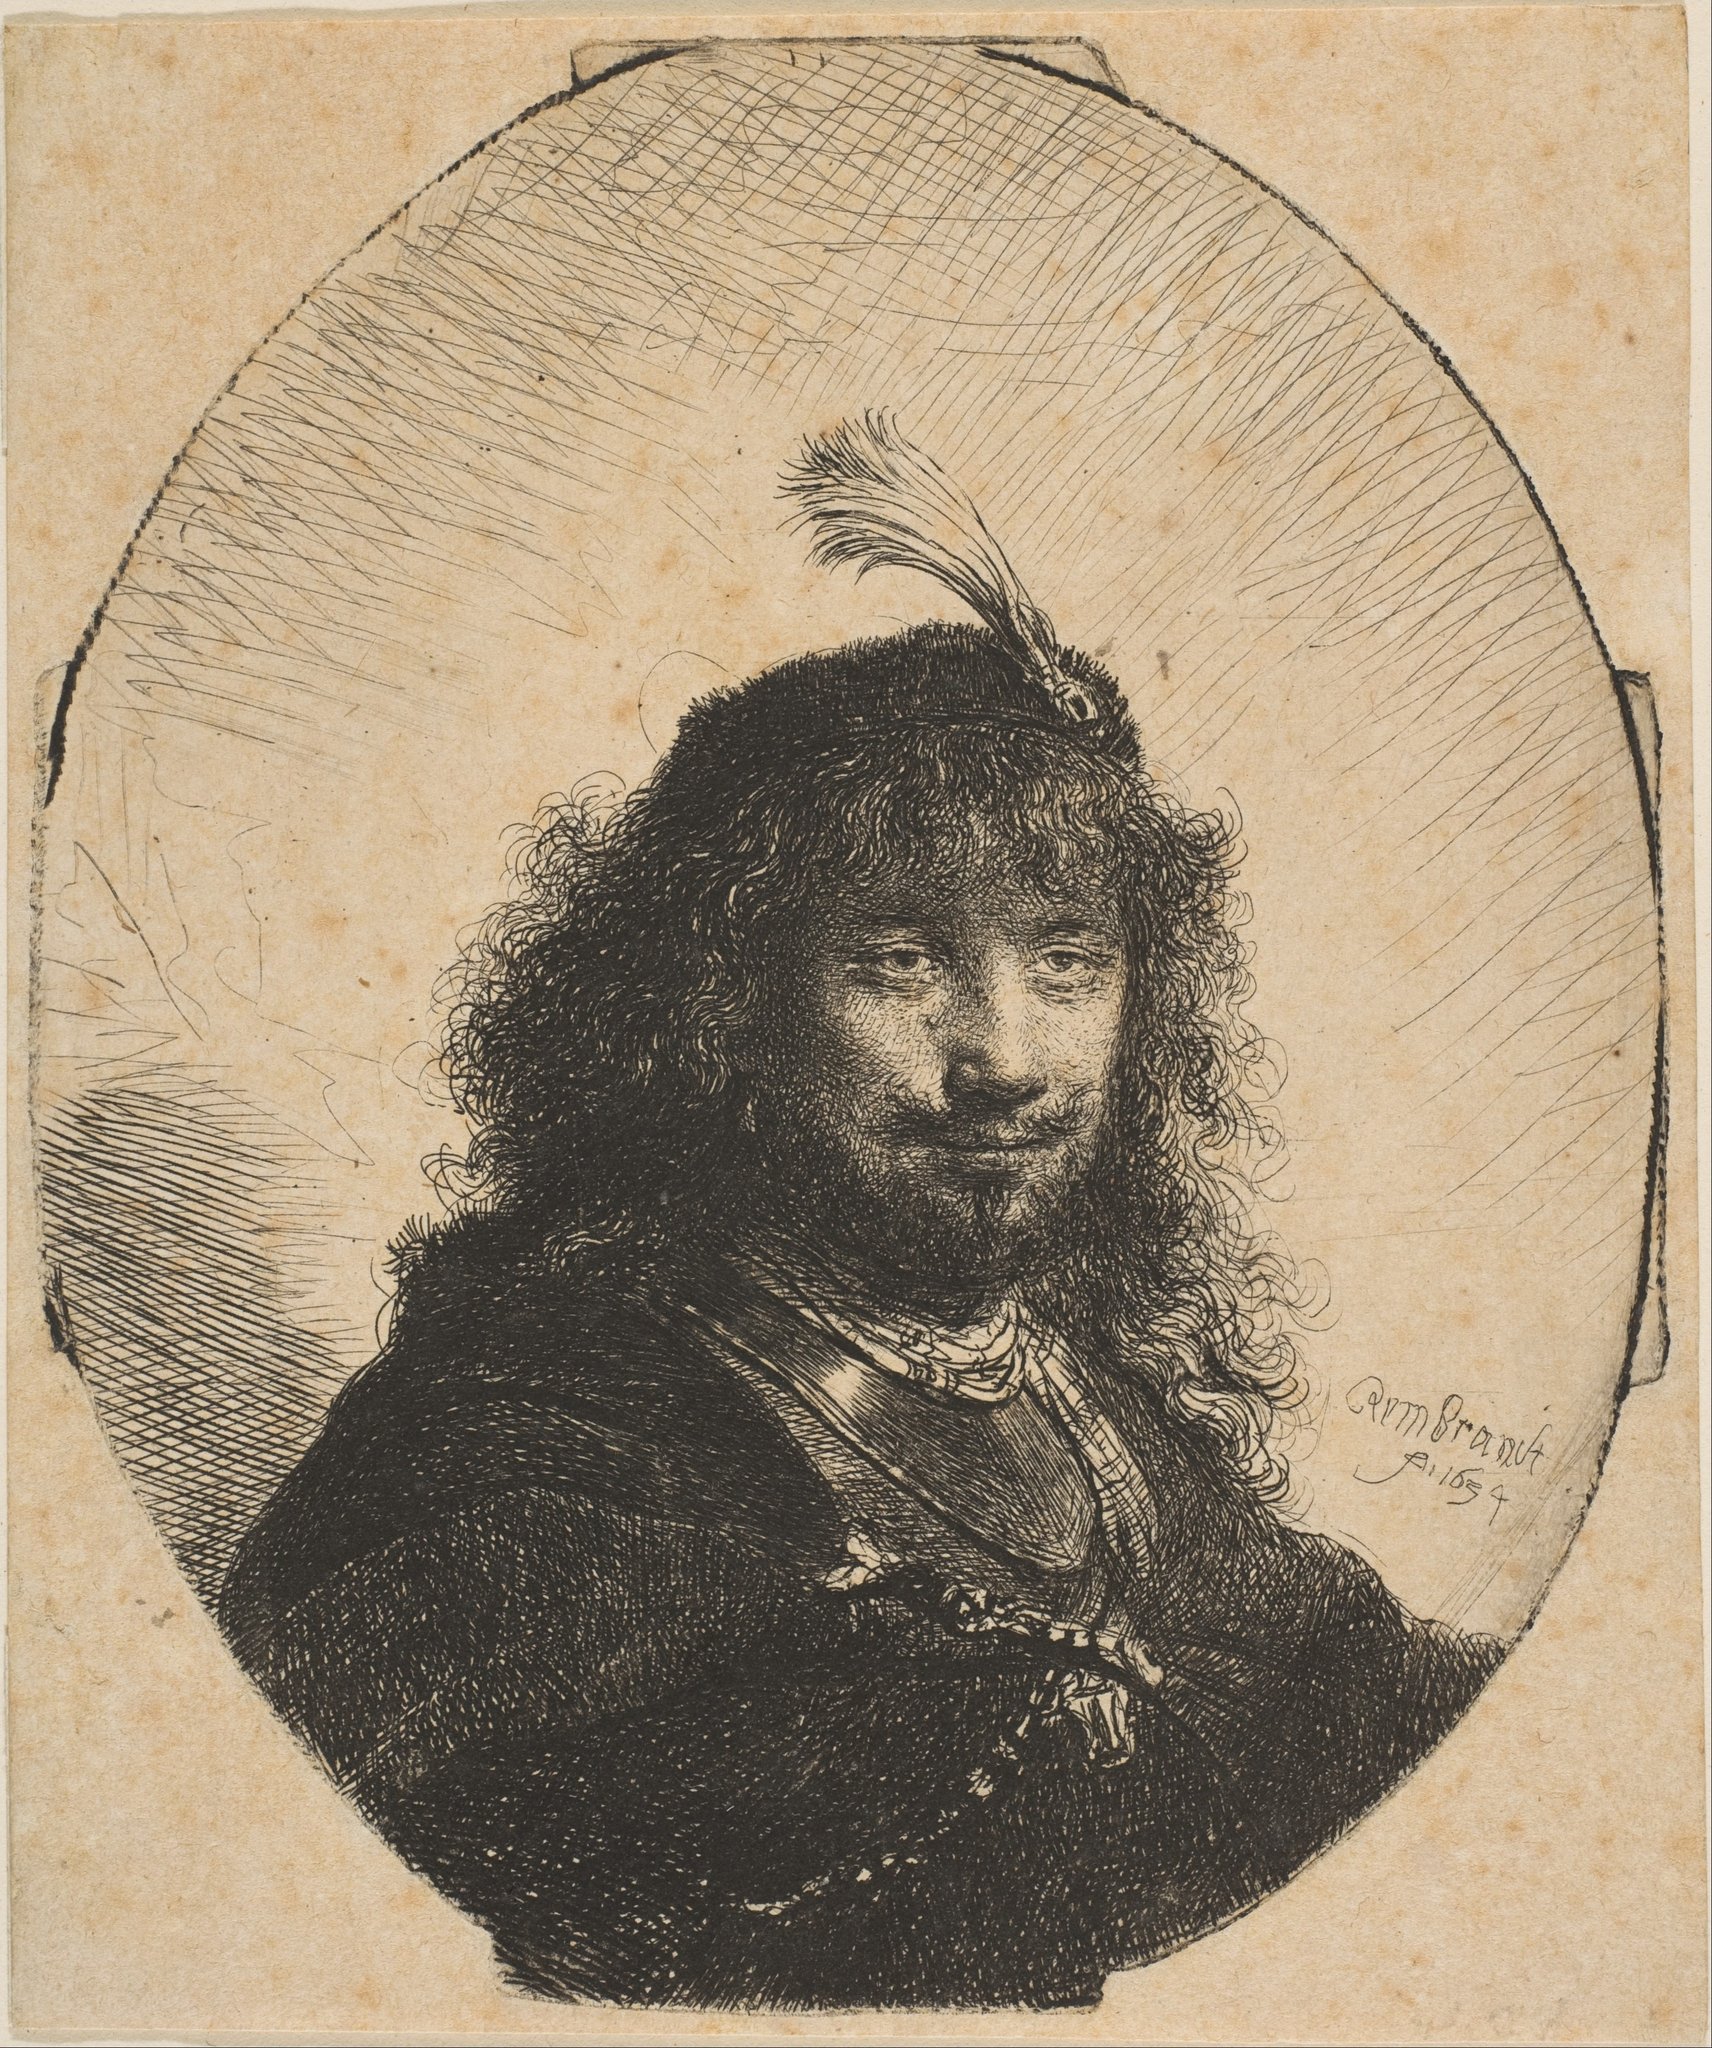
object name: print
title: Self-Portrait with Plumed Cap and Lowered Sabre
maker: rembrandt van rijn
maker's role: artist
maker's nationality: dutch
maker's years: 1606-1669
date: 1634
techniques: etching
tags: men,self-portraits